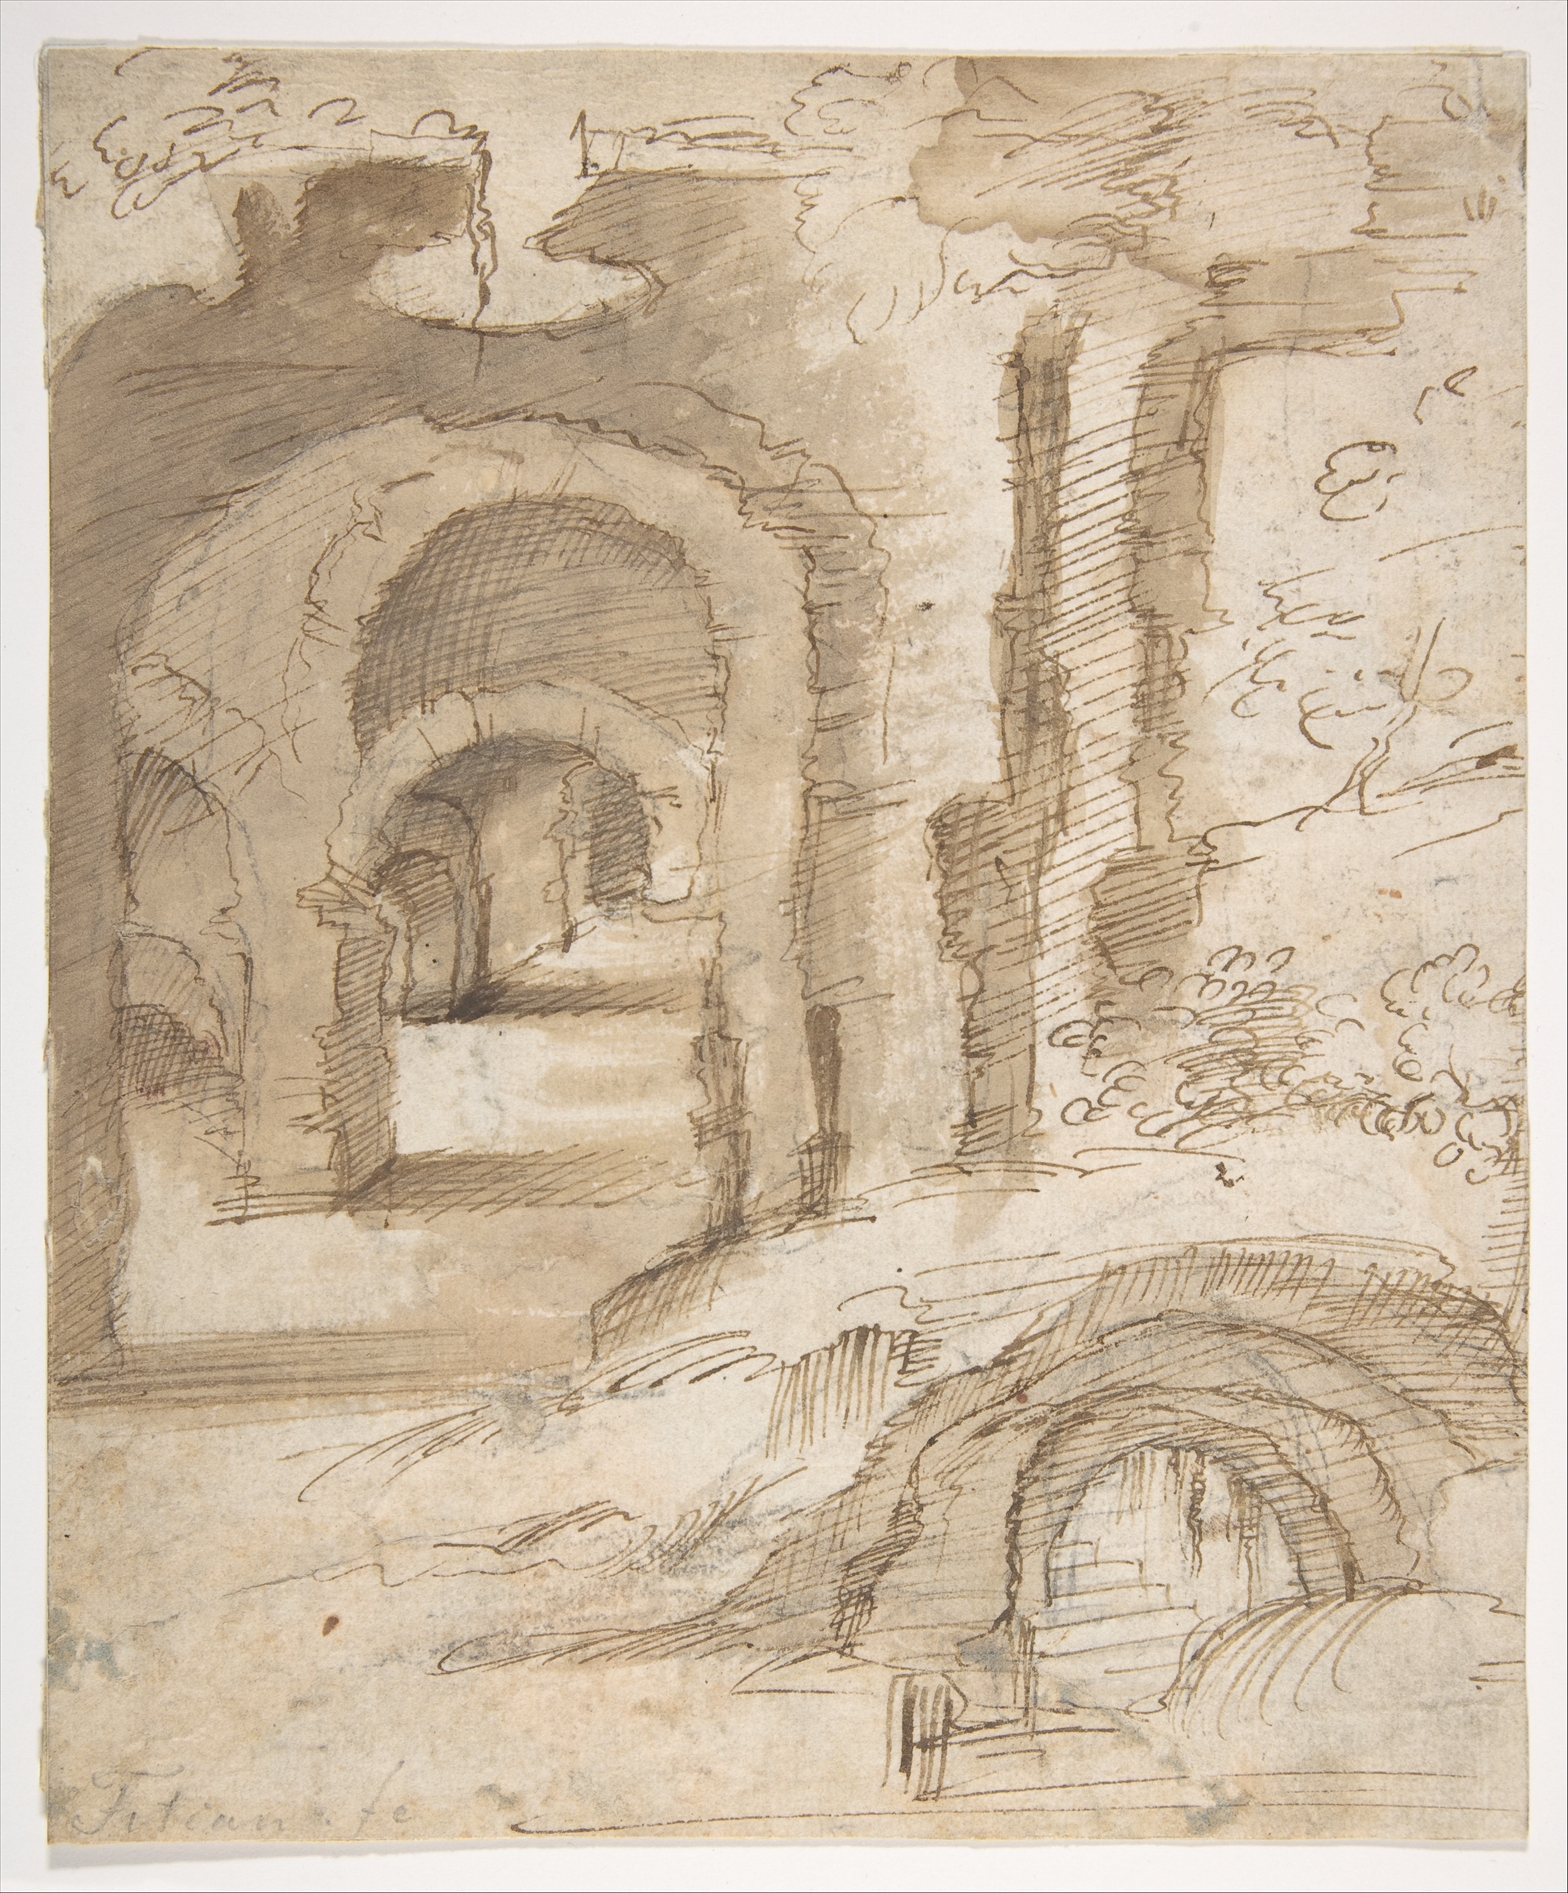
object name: drawing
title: Landscape with Catacombs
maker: domenico beccafumi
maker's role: artist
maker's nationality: italian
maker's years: 1484-1551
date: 1530-1540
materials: chalk, ink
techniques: brush, pen, wash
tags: arches